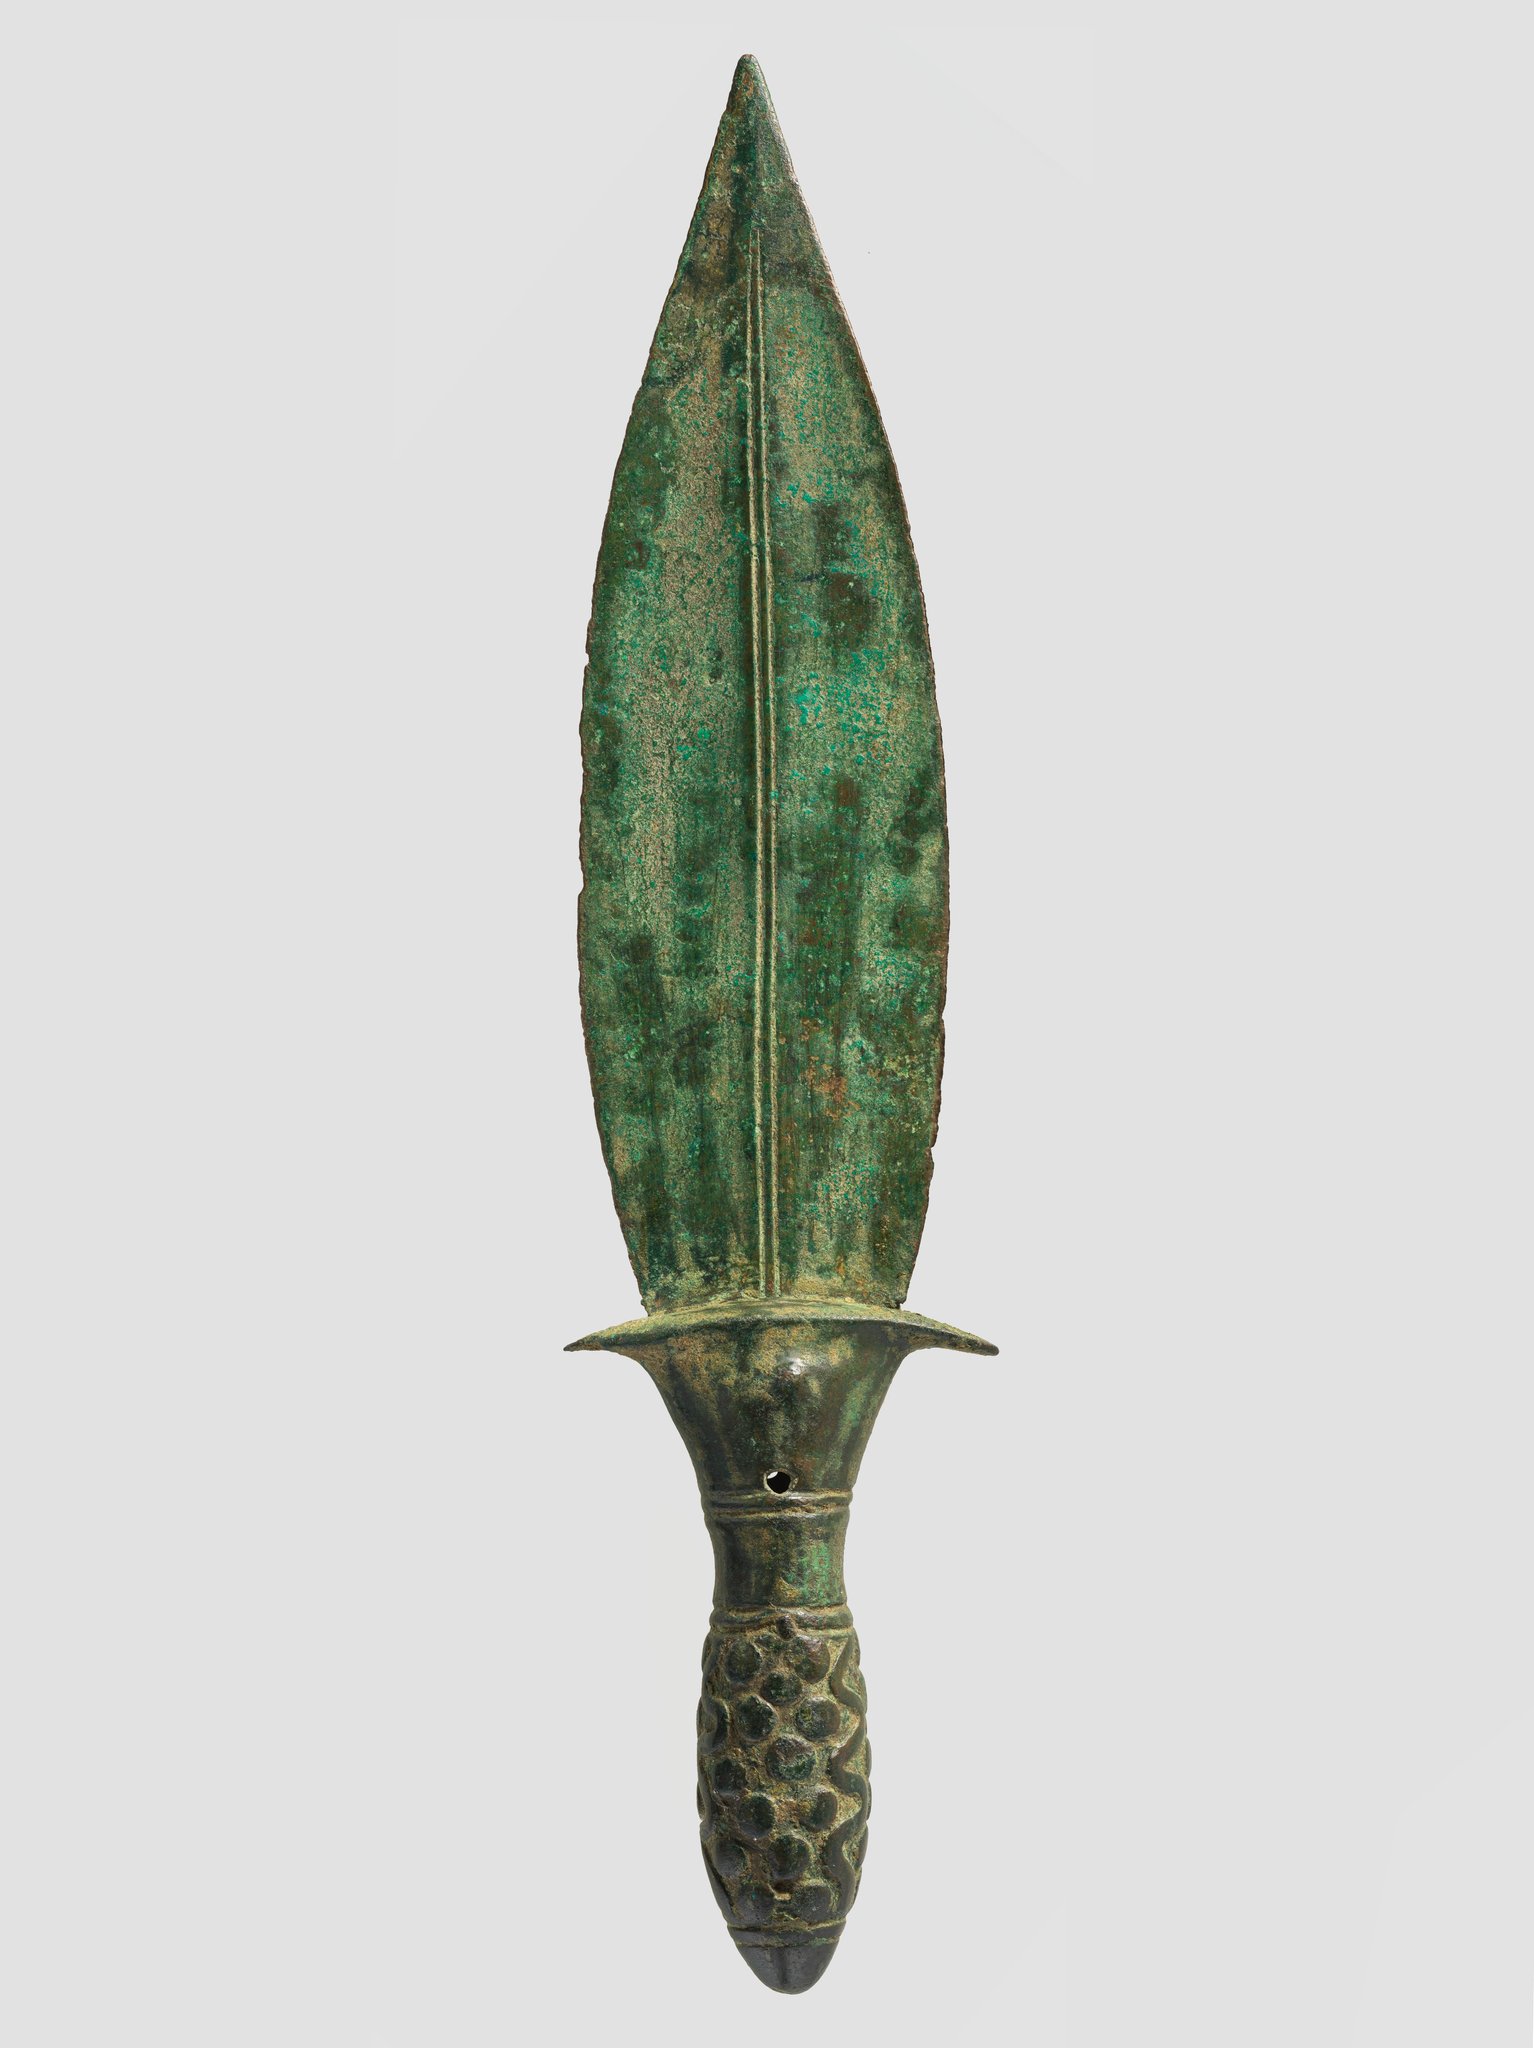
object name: dagger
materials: bronze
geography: iran or mesopotamia